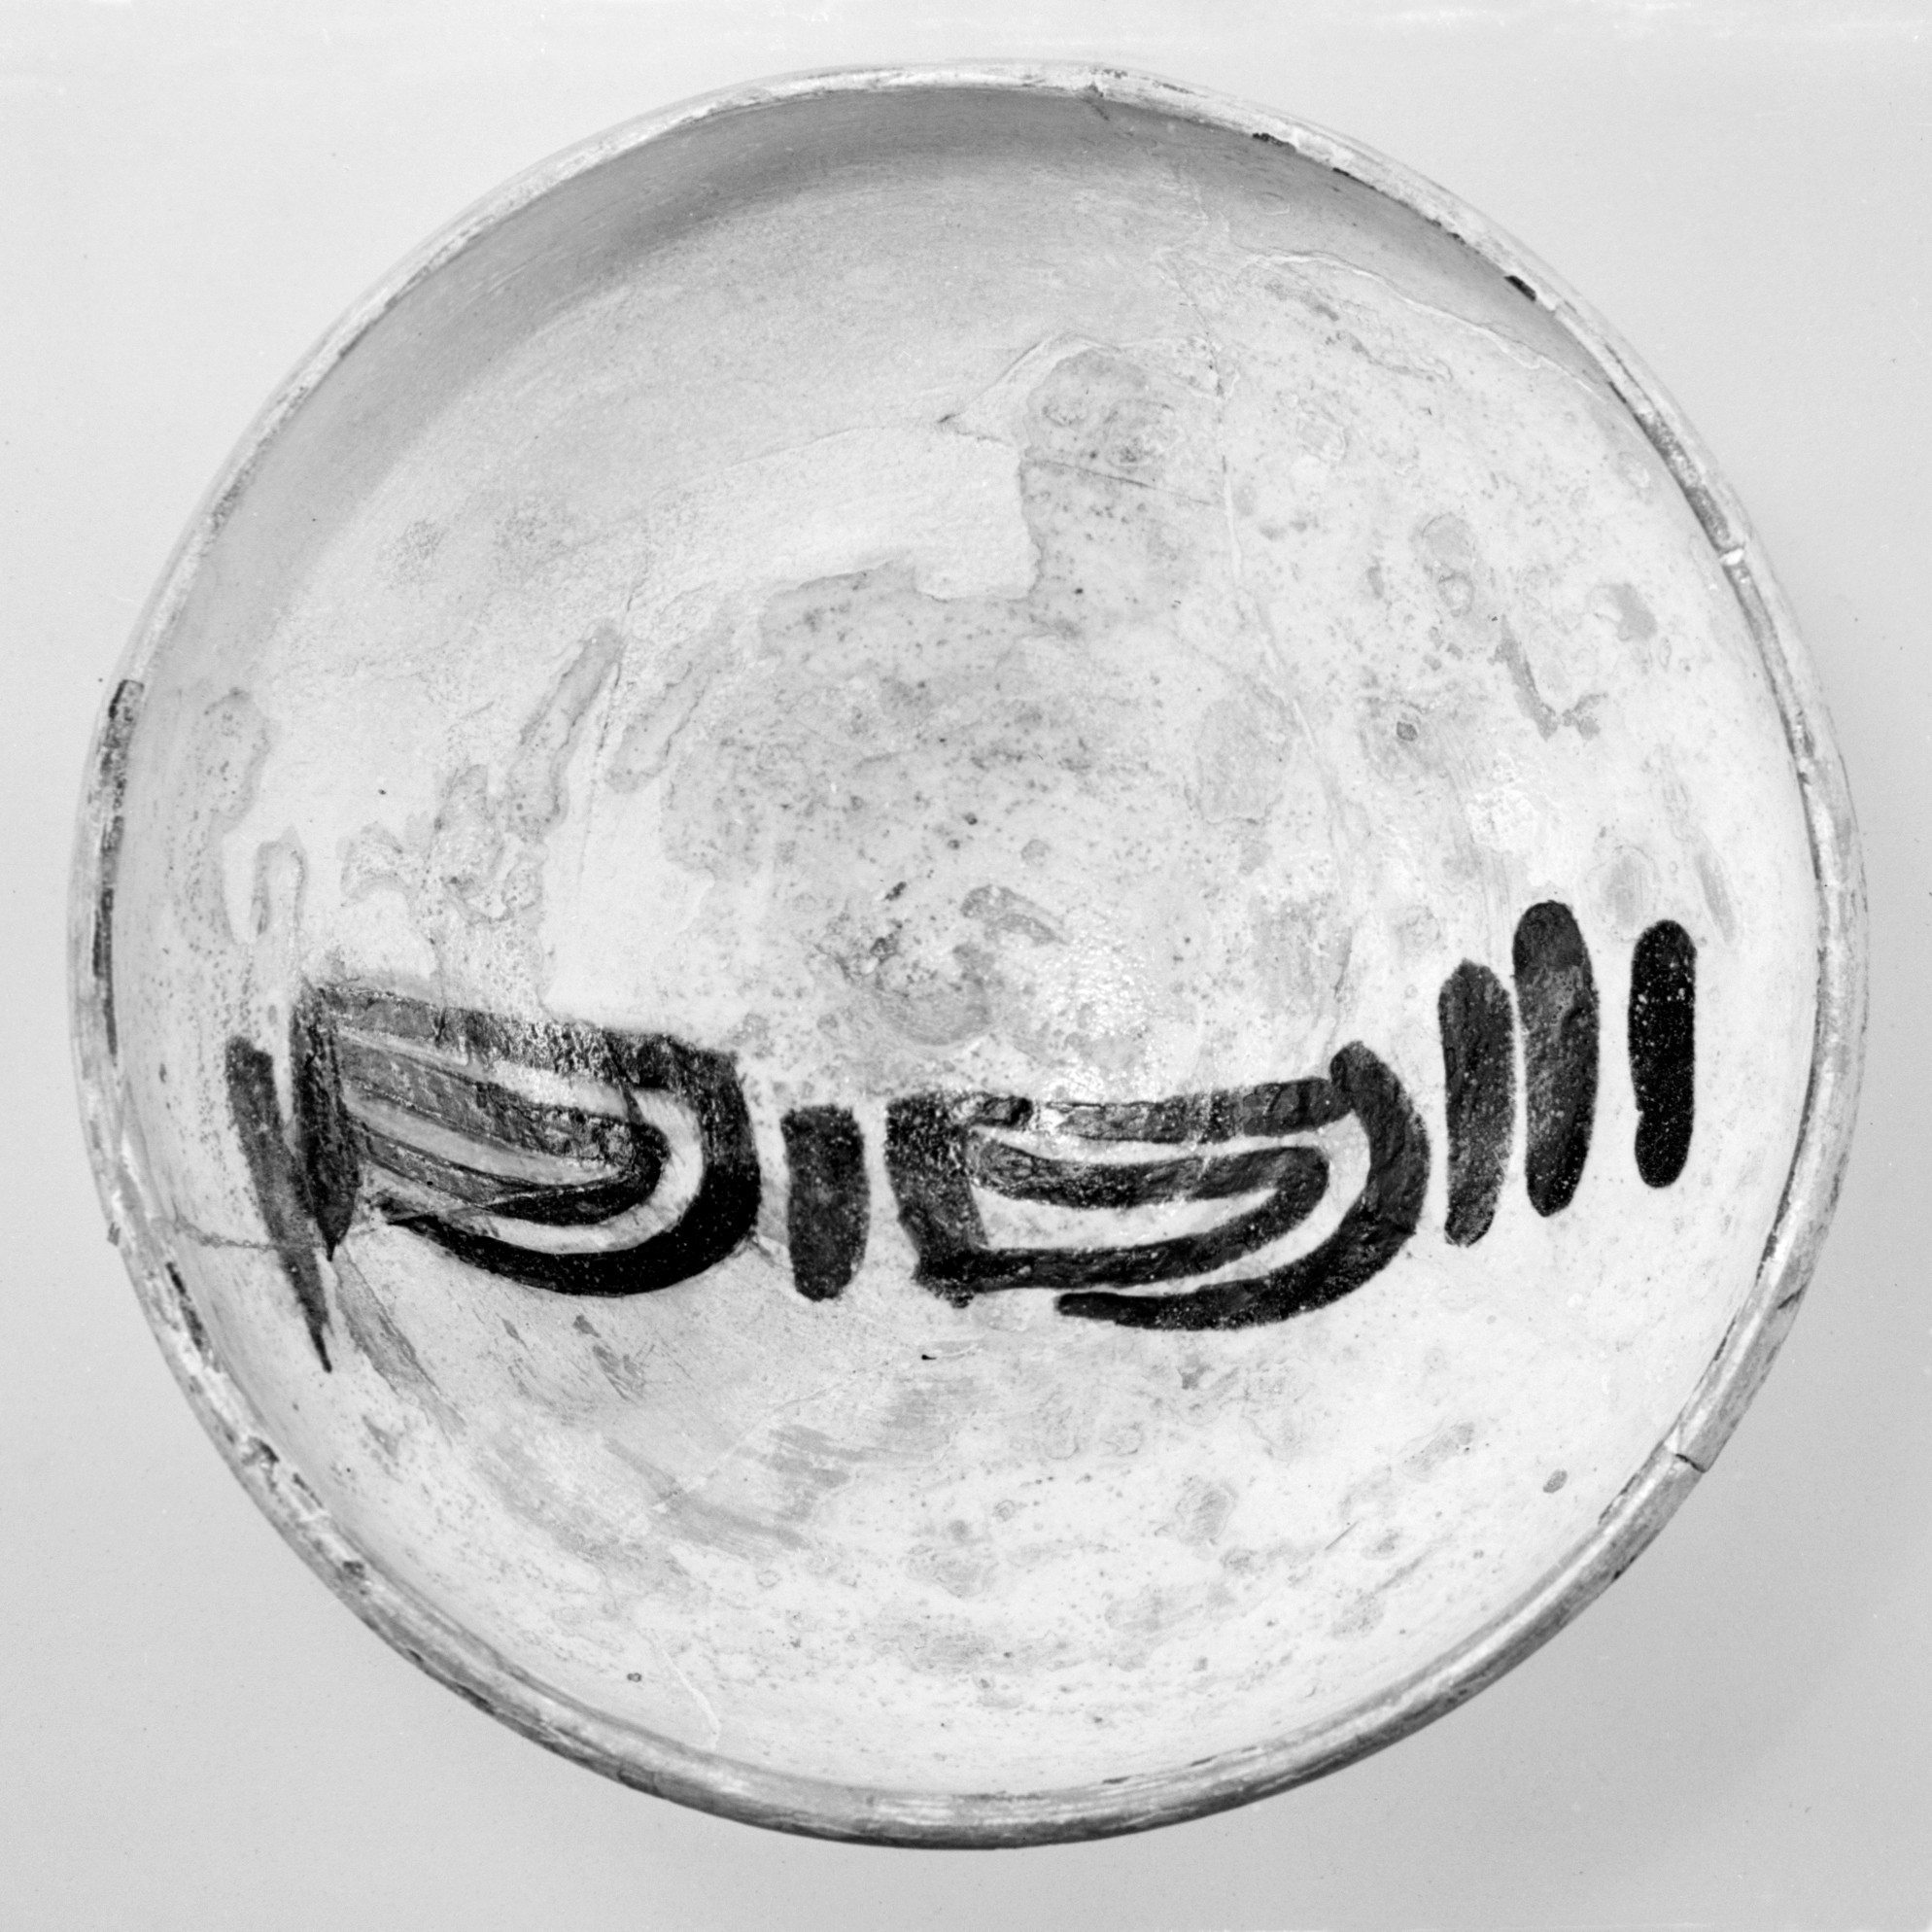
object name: bowl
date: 901-1000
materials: earthenware, glaze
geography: iran